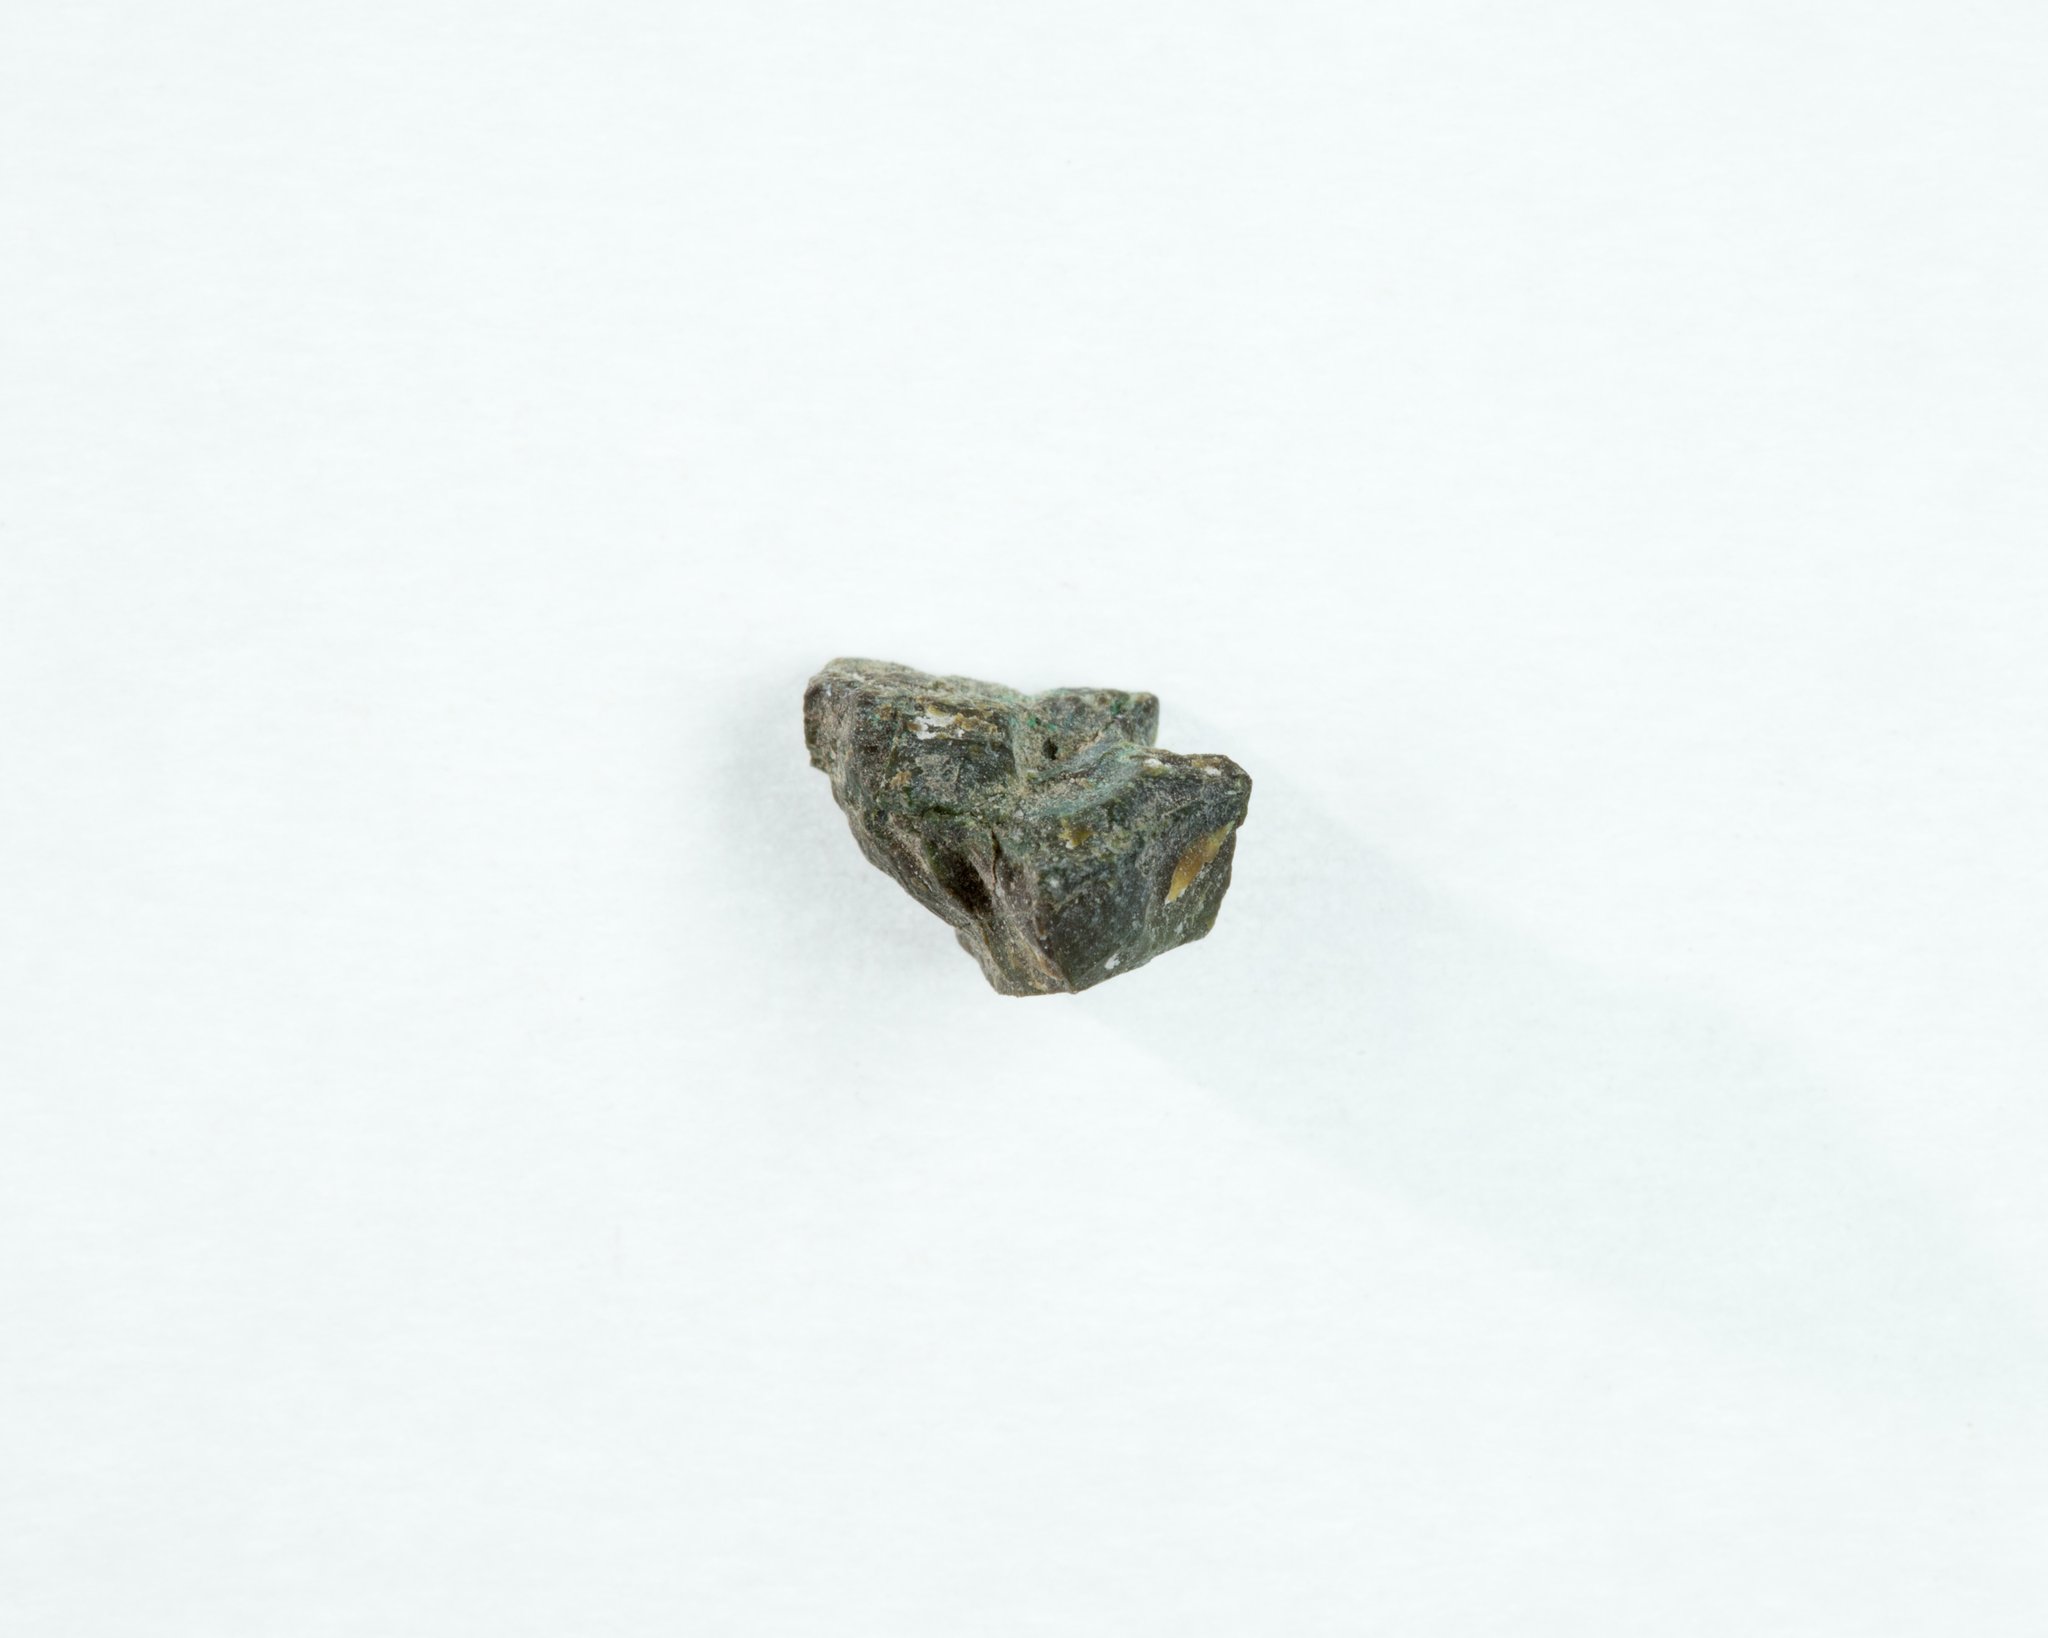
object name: malachite fragment 3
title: Fragments of Malachite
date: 1479-1458 BCE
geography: egypt